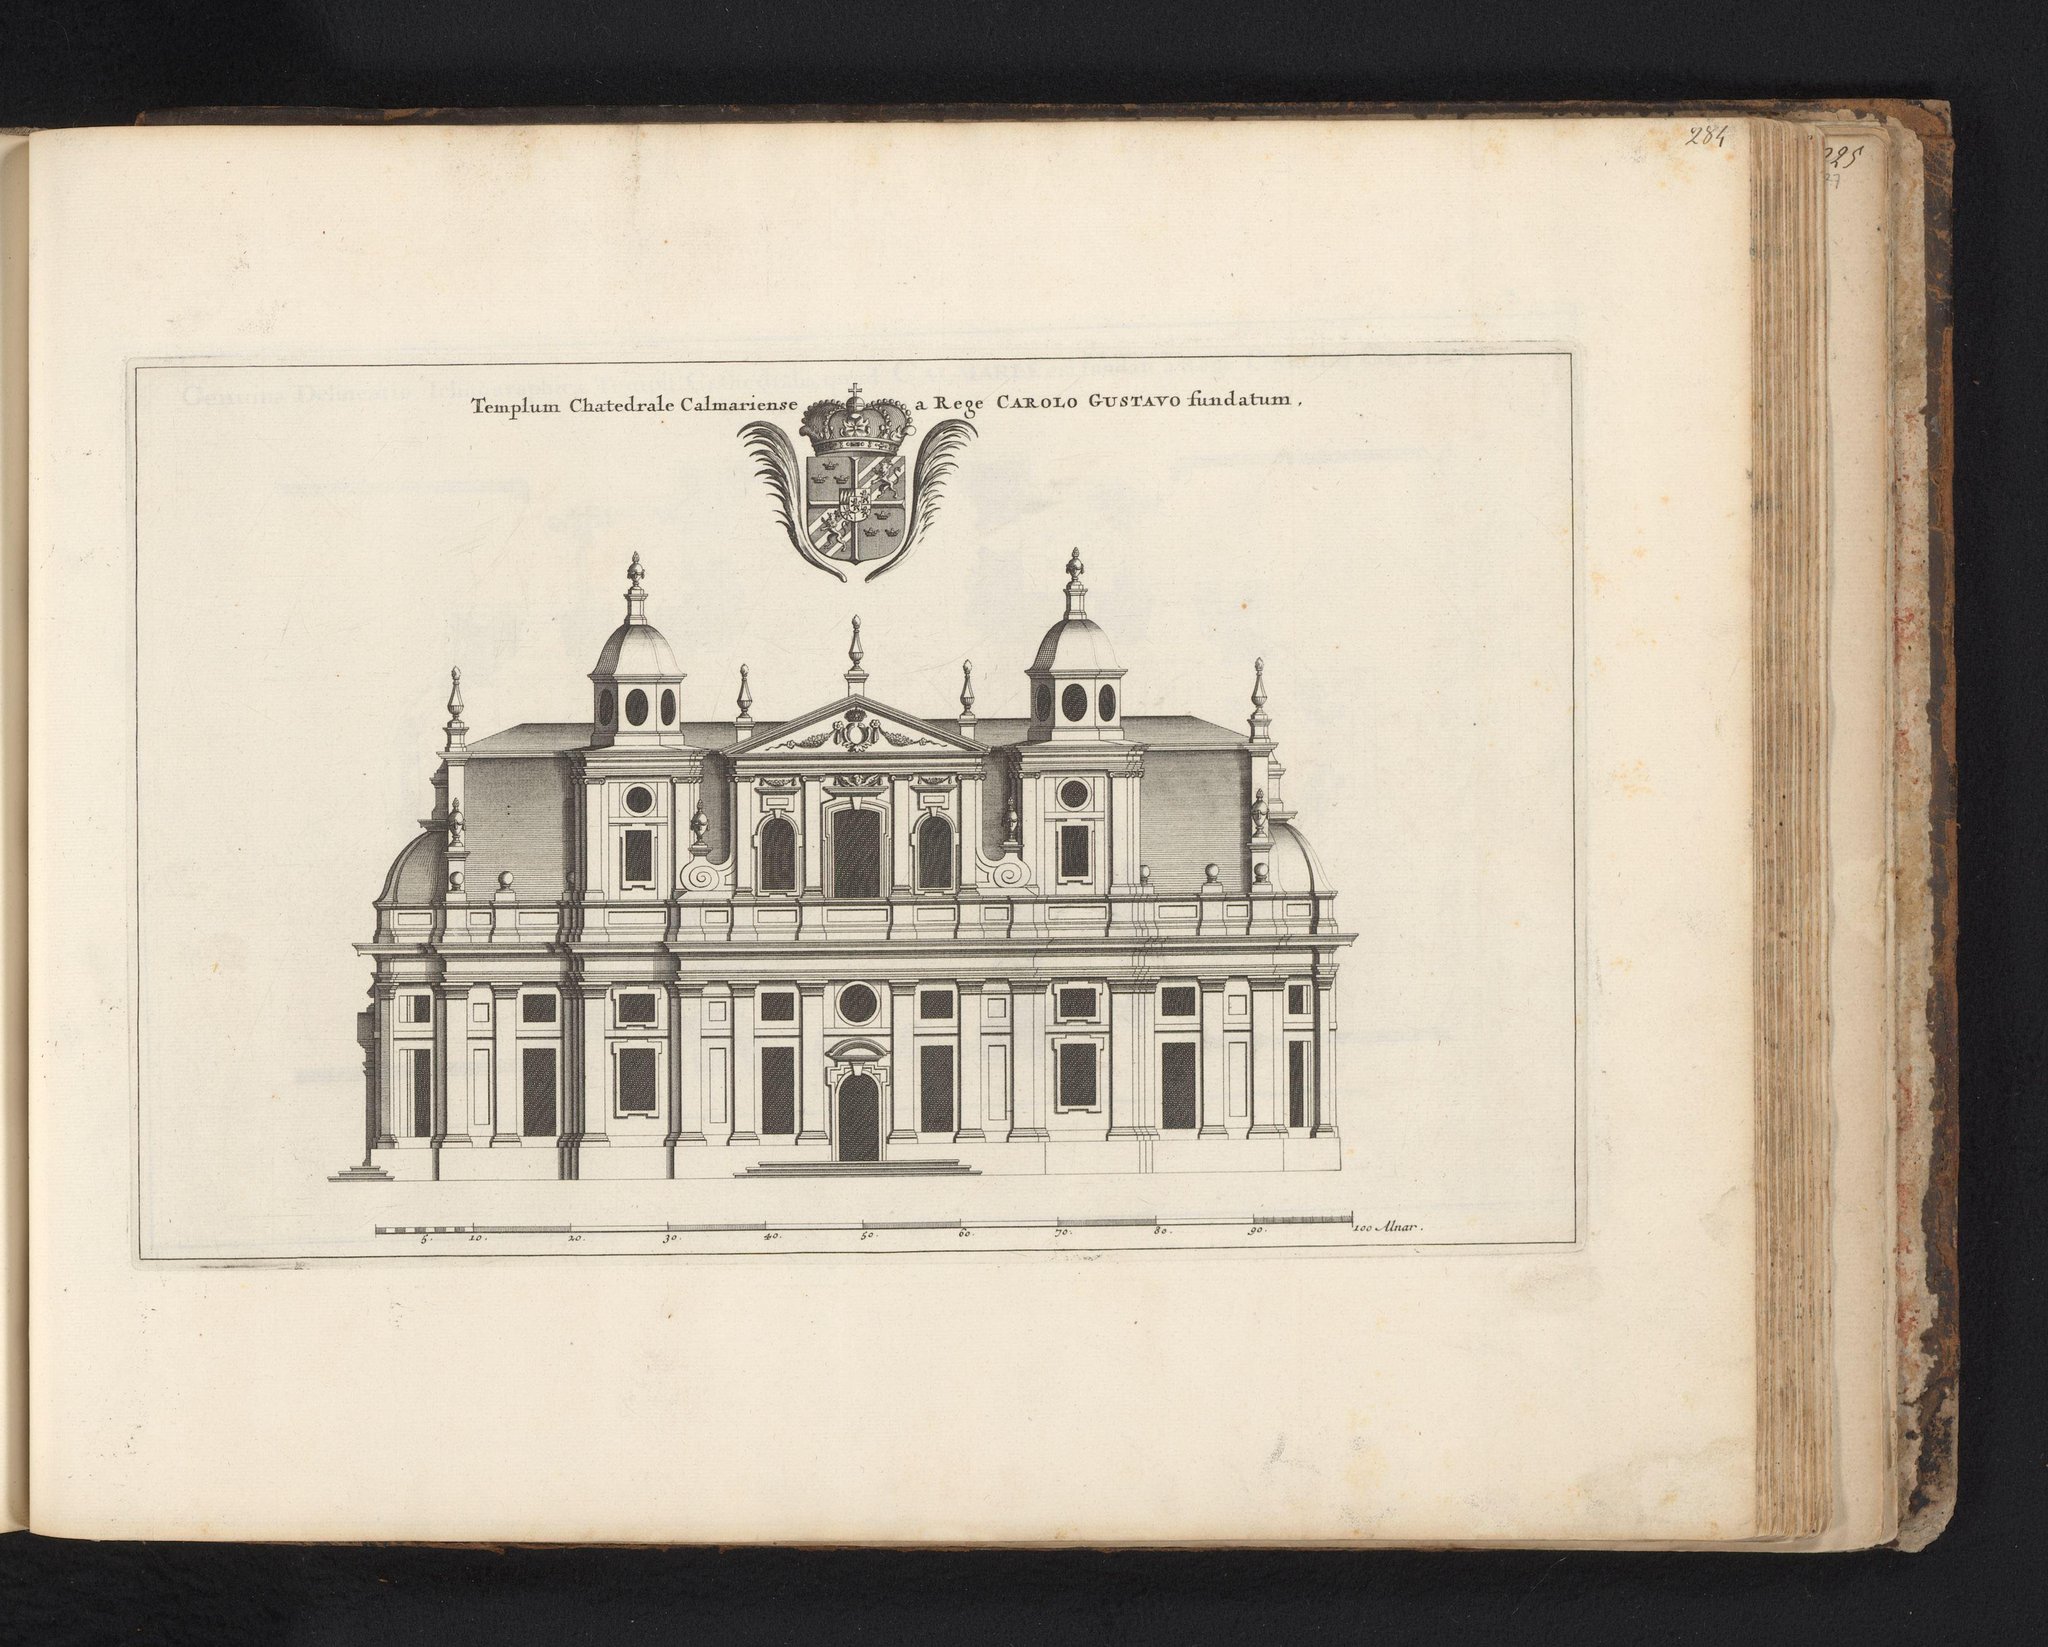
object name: print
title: Gevel van de Dom van Kalmar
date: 1693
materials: paper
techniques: etching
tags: church (exterior)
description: Kungliga Biblioteket, 'Suecia': http://www.kb.se/samlingarna/Kartor-bilder/Suecia-antiqua/ (geraadpleegd november 2016).